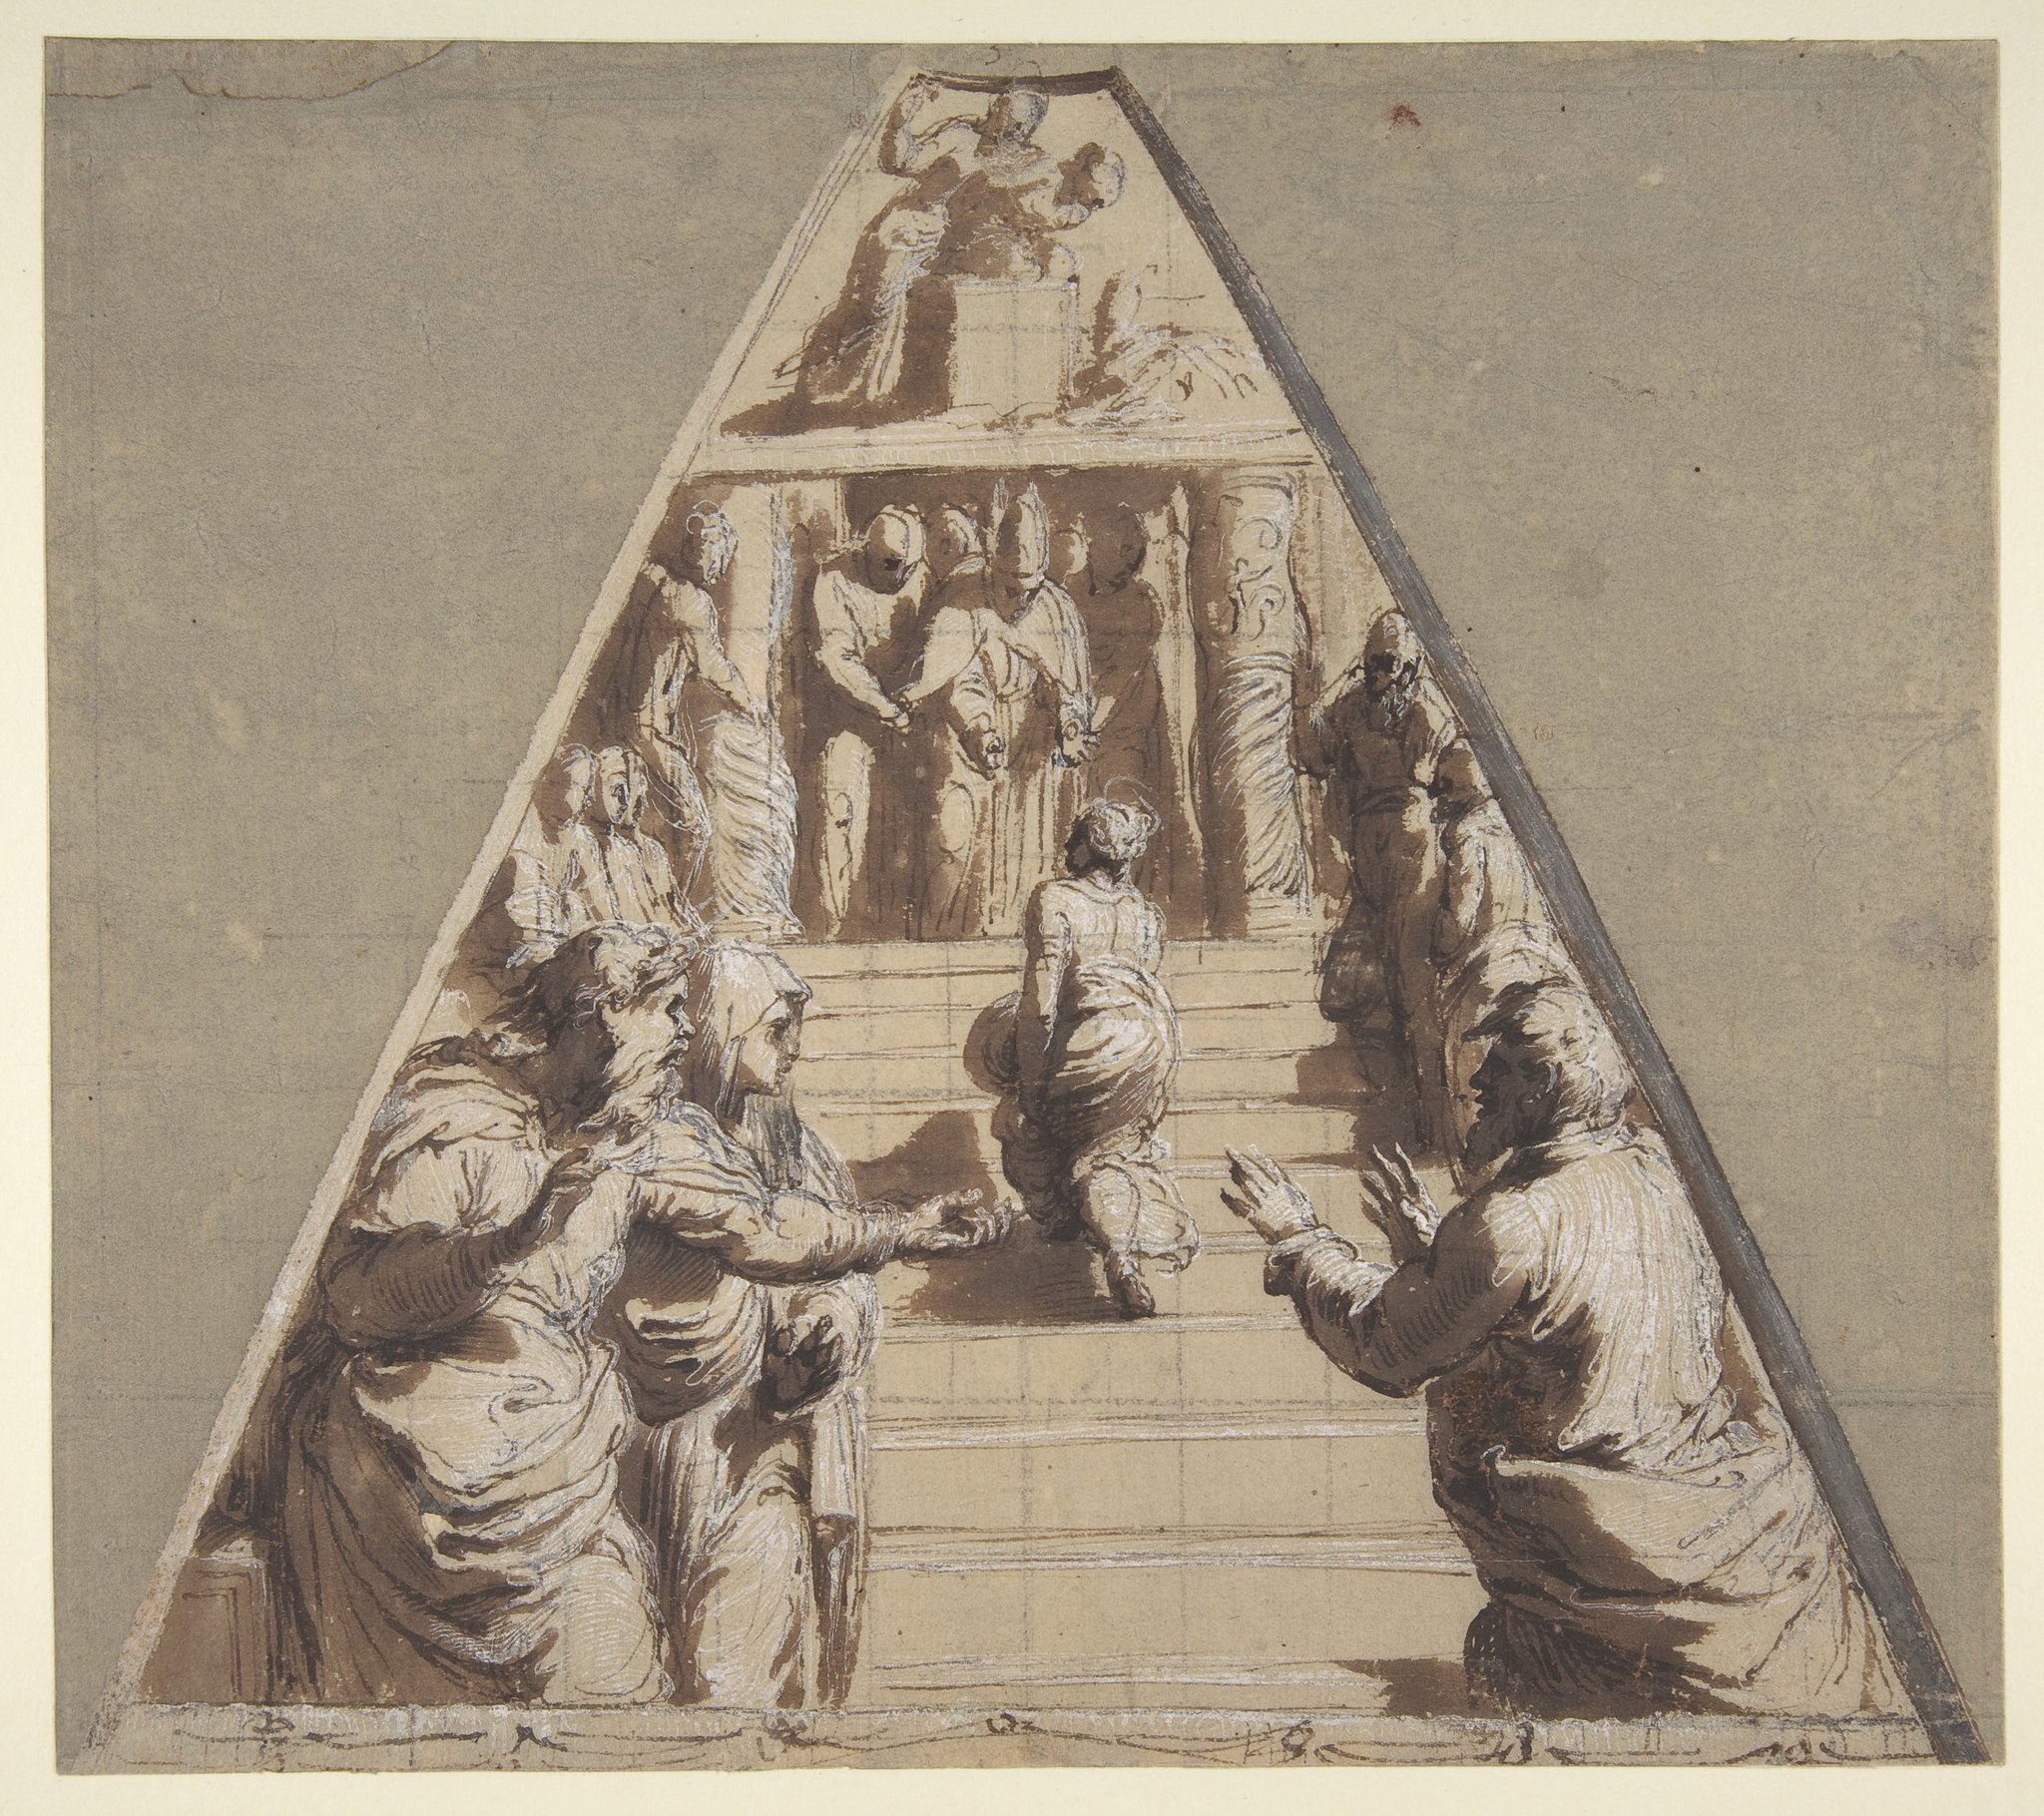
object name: drawing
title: Presentation of the Virgin in the Temple (below), Abraham about to Sacrifice Isaac (above)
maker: perino del vaga (pietro buonaccorsi)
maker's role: artist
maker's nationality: italian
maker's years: 1501-1547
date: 1520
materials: chalk, gouache, ink, paper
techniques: brush, highlighting, pen, drawing, tinting, wash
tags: temples,men,women,virgin mary,abraham